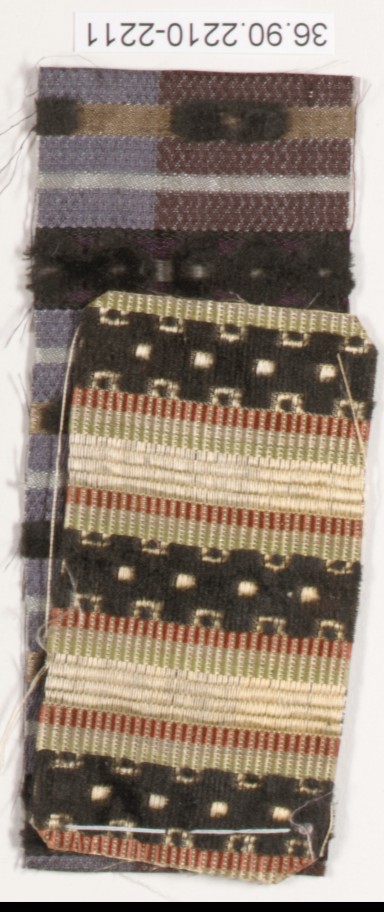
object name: piece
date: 1801-1900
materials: silk